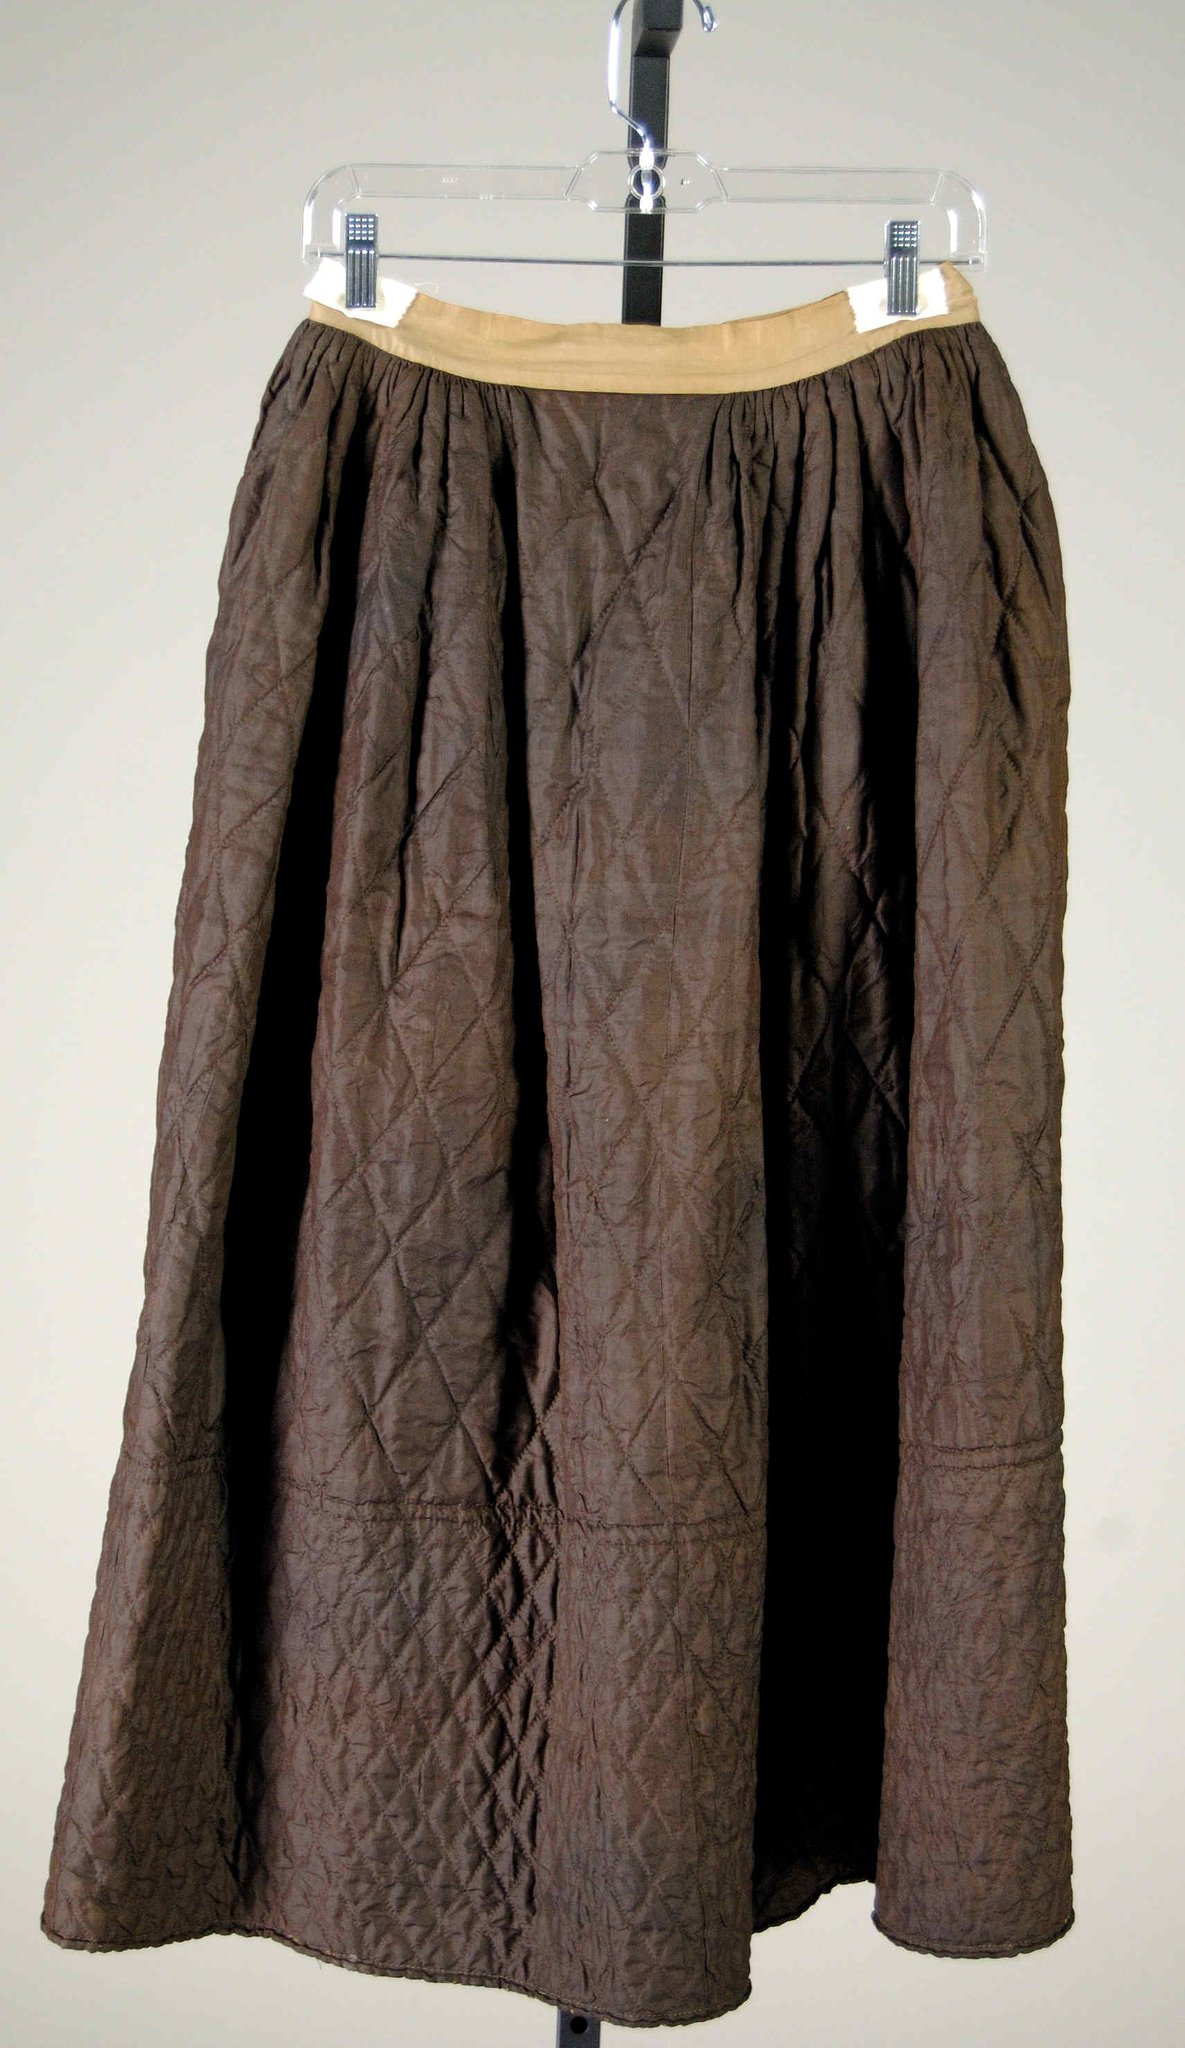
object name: petticoat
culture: american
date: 1776-1800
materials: cotton, silk